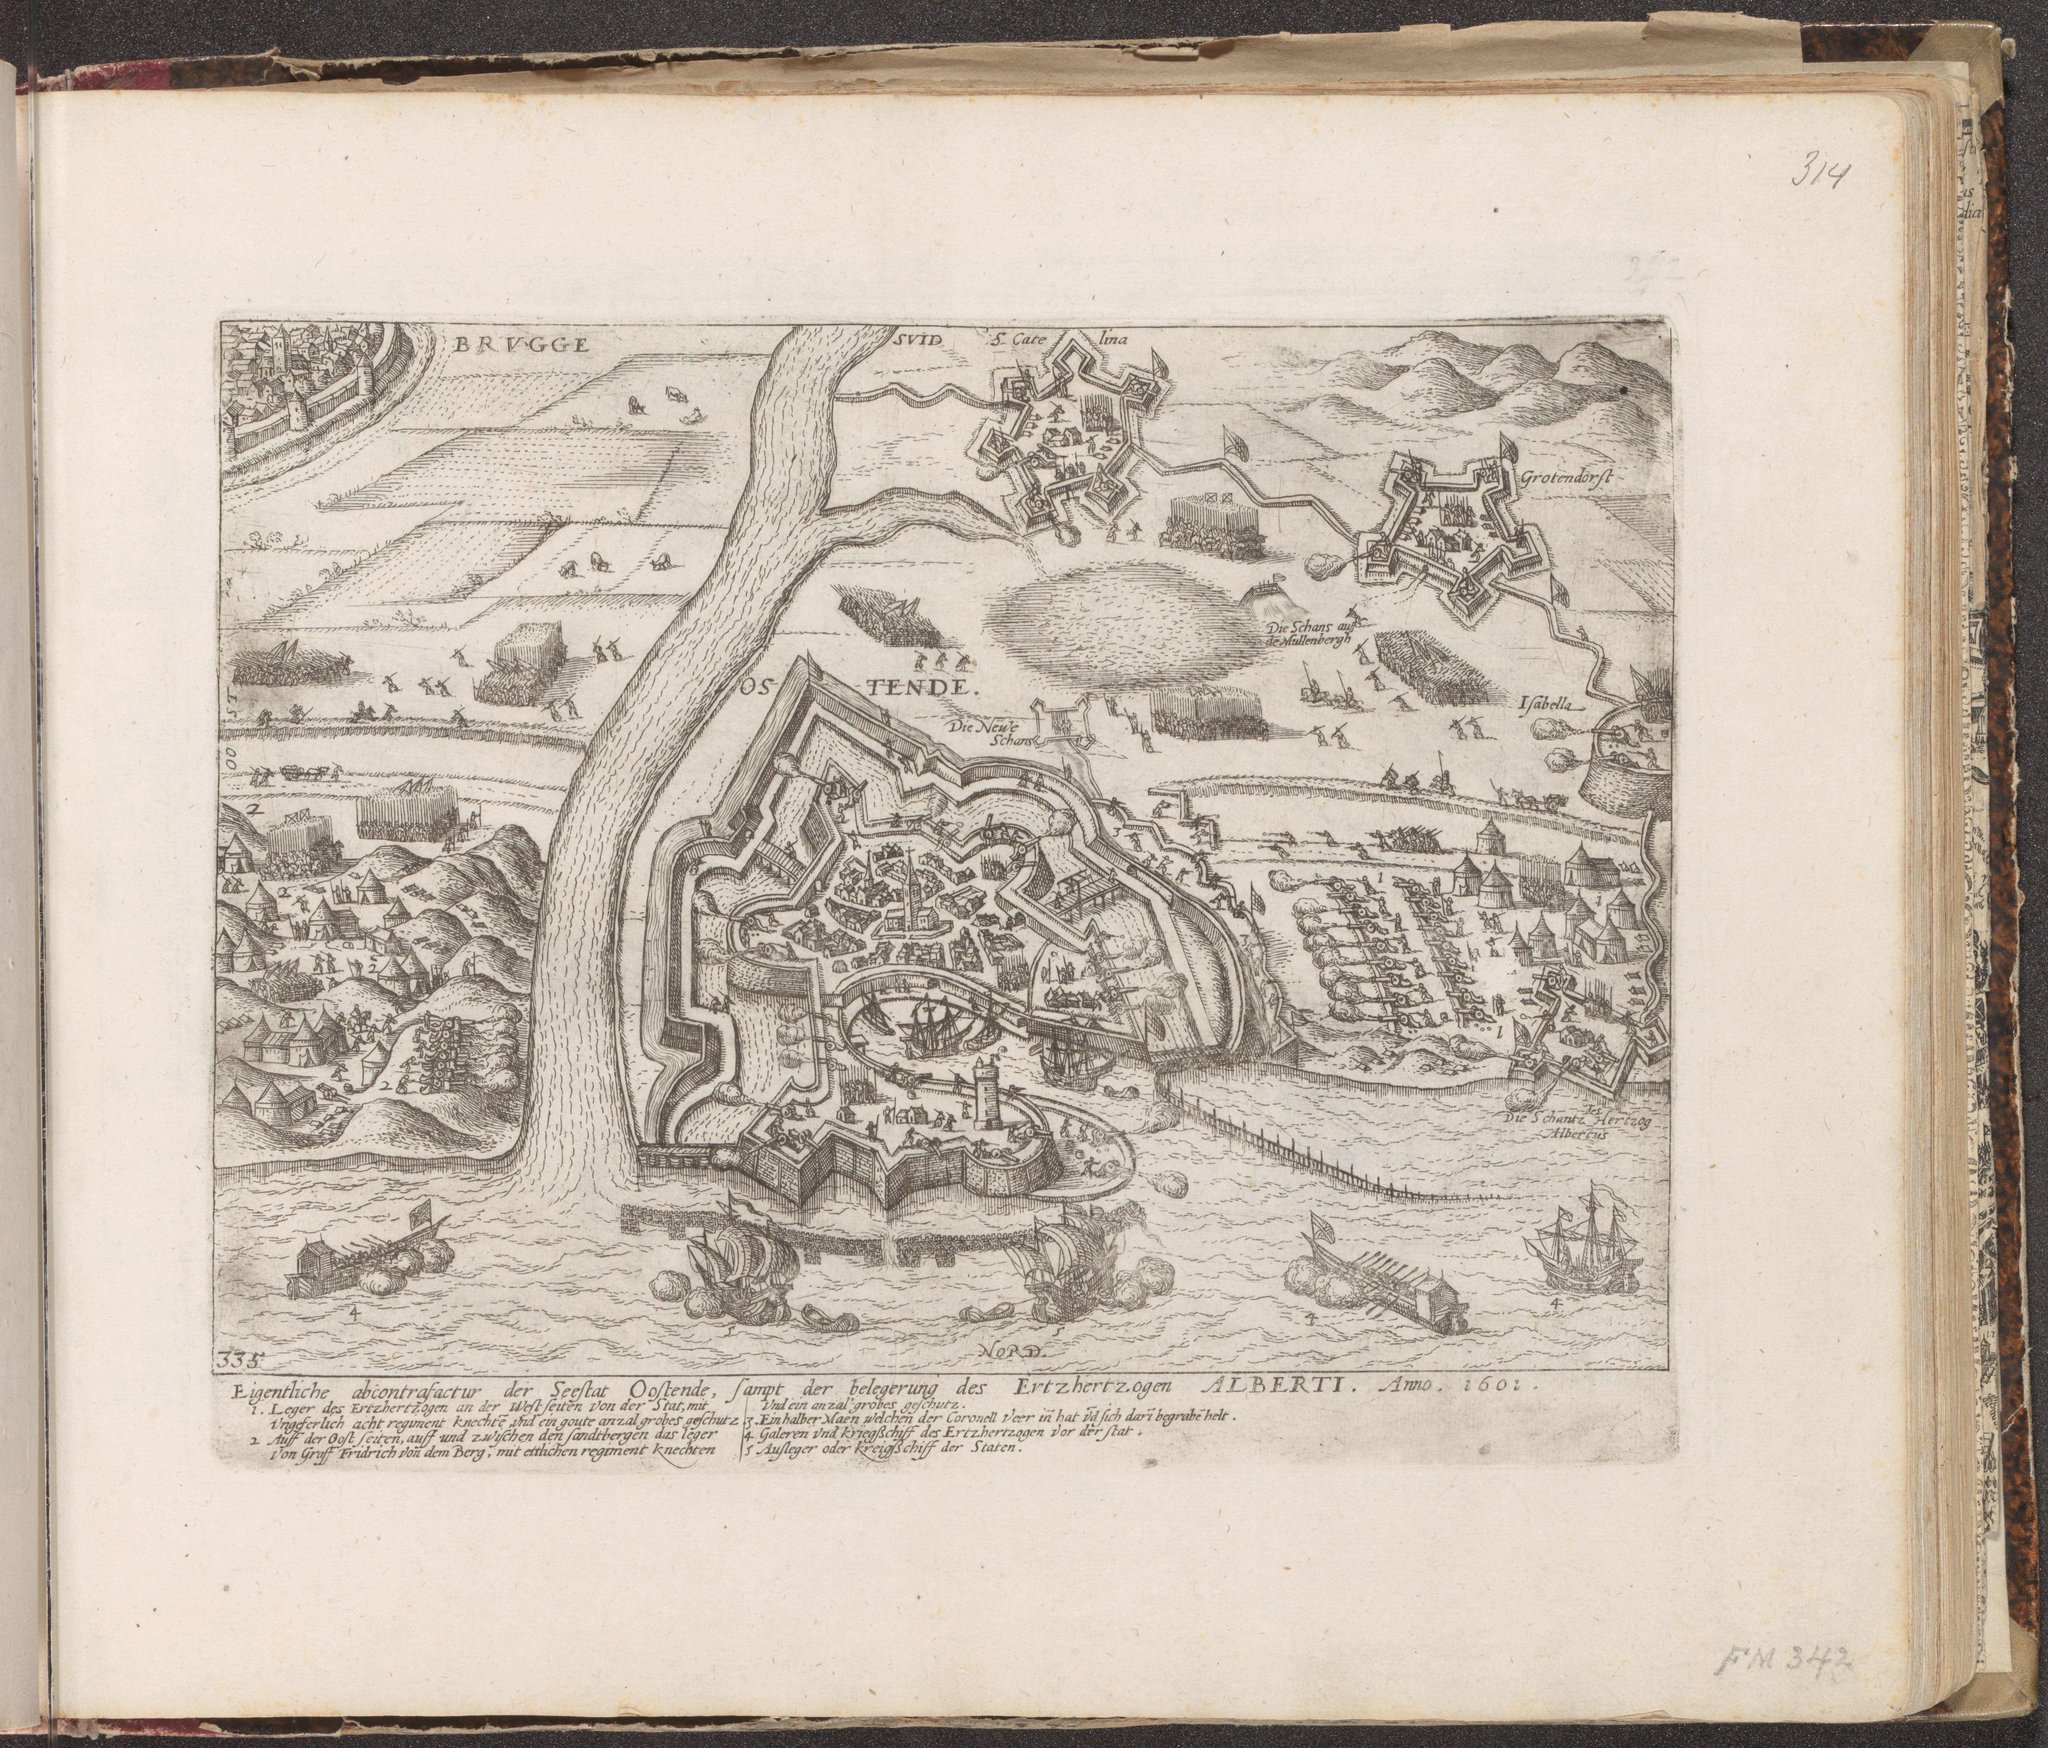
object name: album leaf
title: Beleg van Oostende, 1601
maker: frans hogenberg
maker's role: print maker, publisher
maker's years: 1538-1590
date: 1601-1603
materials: paper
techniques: etching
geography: cologne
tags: siege, position war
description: Oostende belegerd door het leger van Albrecht. Plan van de stad en omgeving met de stellingen van de troepen van aartshertog Albertus. Aanvang van het beleg op 5 juli 1601. In het onderschrift de verklaring van de cijfers 1-5, in het Duits. Linksonder genummerd: 335. De prent maakt deel uit van een album.